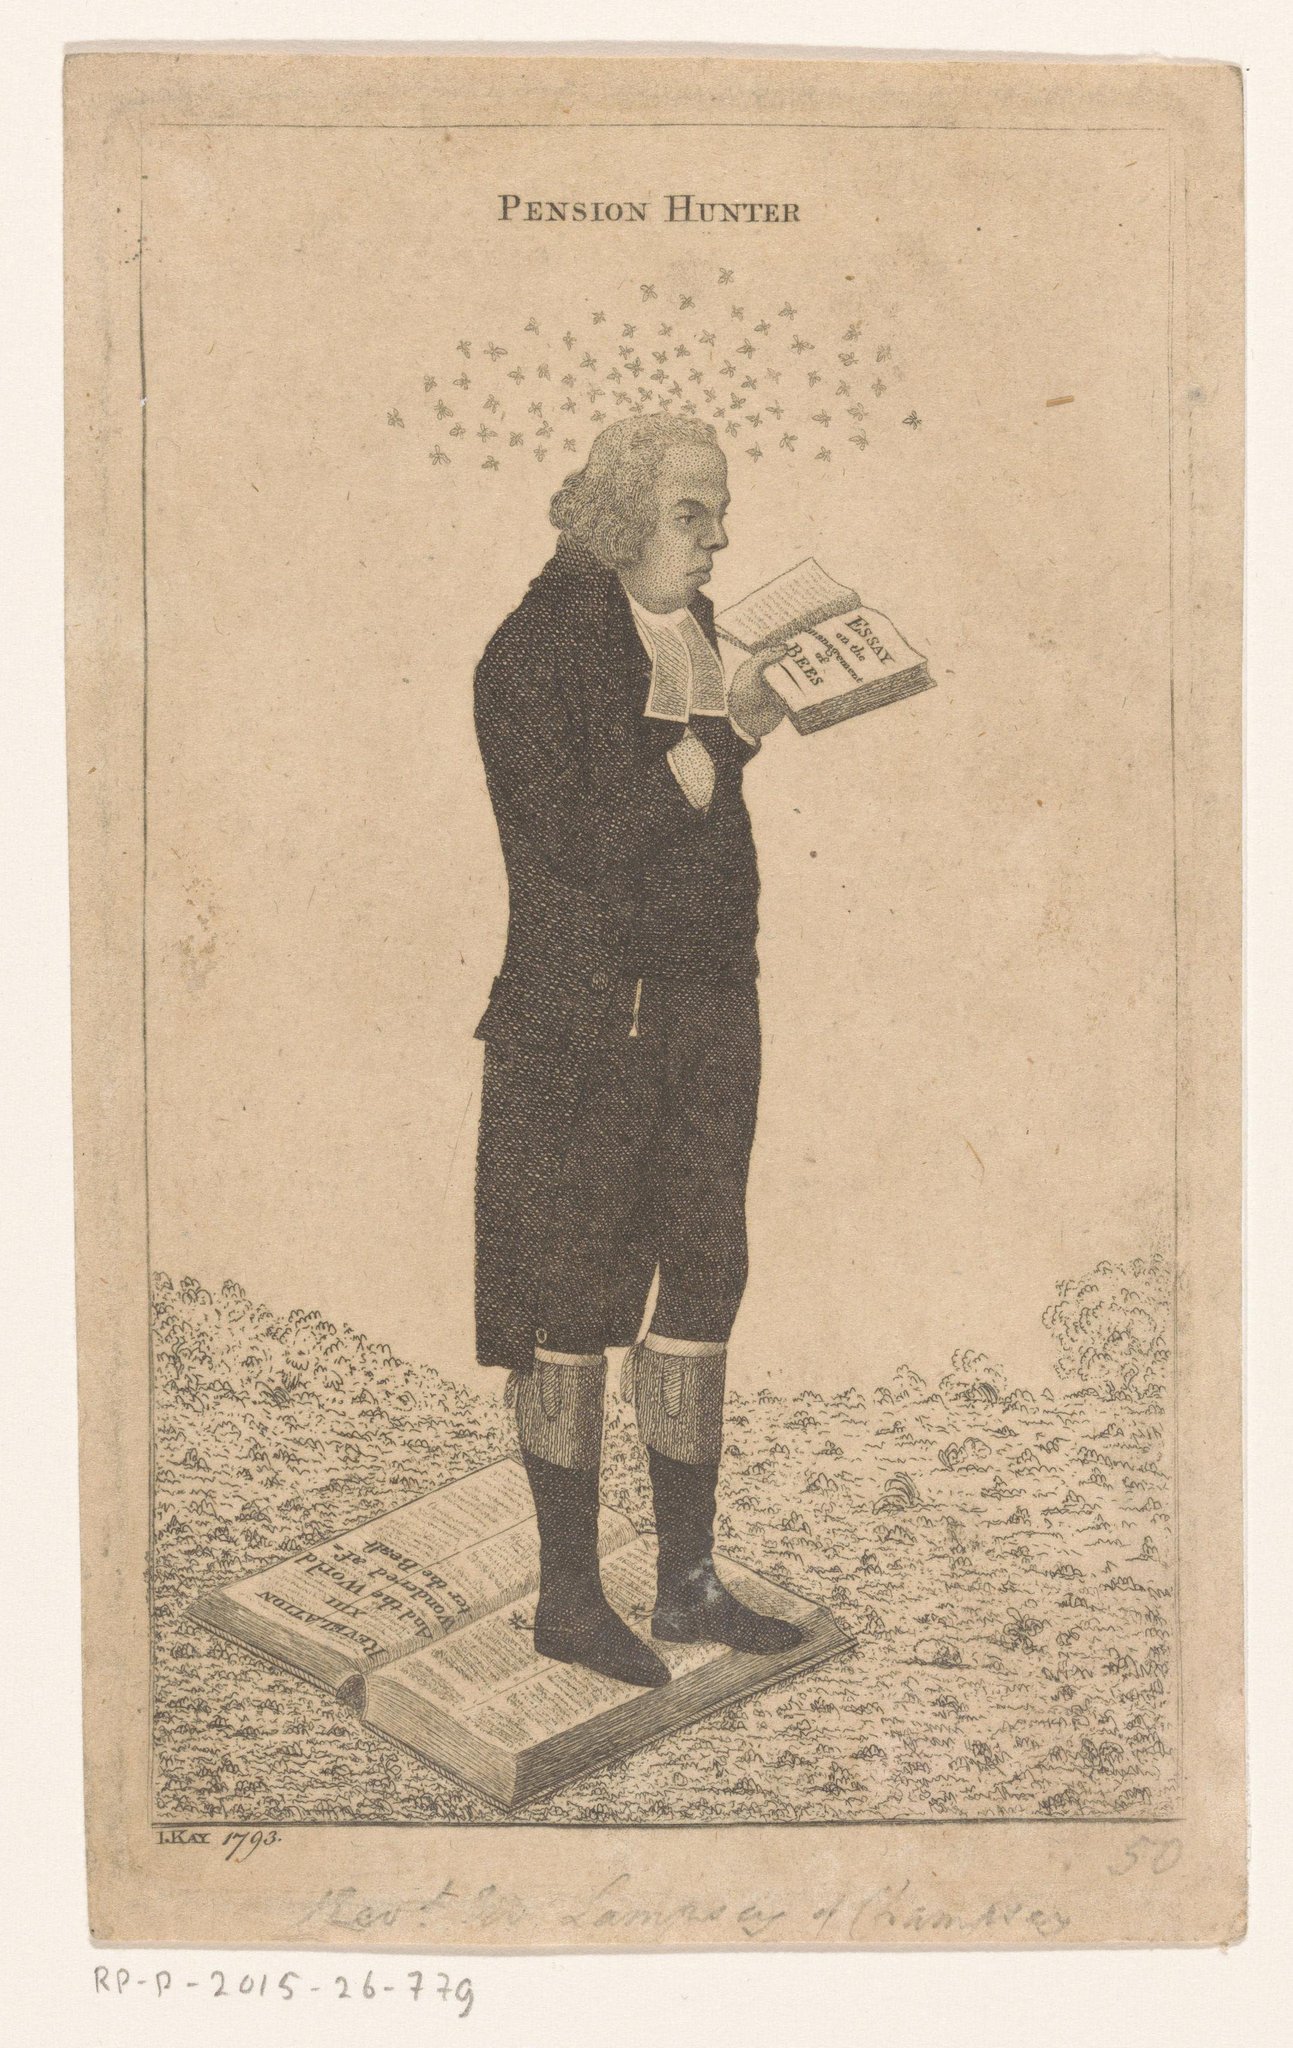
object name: cartoon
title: Portret van dominee James Lapslie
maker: john kay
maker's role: print maker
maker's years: 1742-1826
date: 1793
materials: paper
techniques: etching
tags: glasgow, bible, insects: bee, functionaries and dignitaries (with name) ~ protestant churches, political caricatures and satires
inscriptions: collector's mark: Lugt 2228, collector's mark, inscription: ‘Rev.d Mr. Lampsley of Campsey’, collector's mark: Lugt 4779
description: Op een grasveld staat dominee James Lapslie. Aan beide voeten draagt hij laarzen met sporen, waarmee hij op een geopende bijbel staat. In zijn linkerhand houdt hij het door hemzelf geschreven boek: "Essay on the management of Bees", om zijn hoofd vliegt een zwerm bijen.